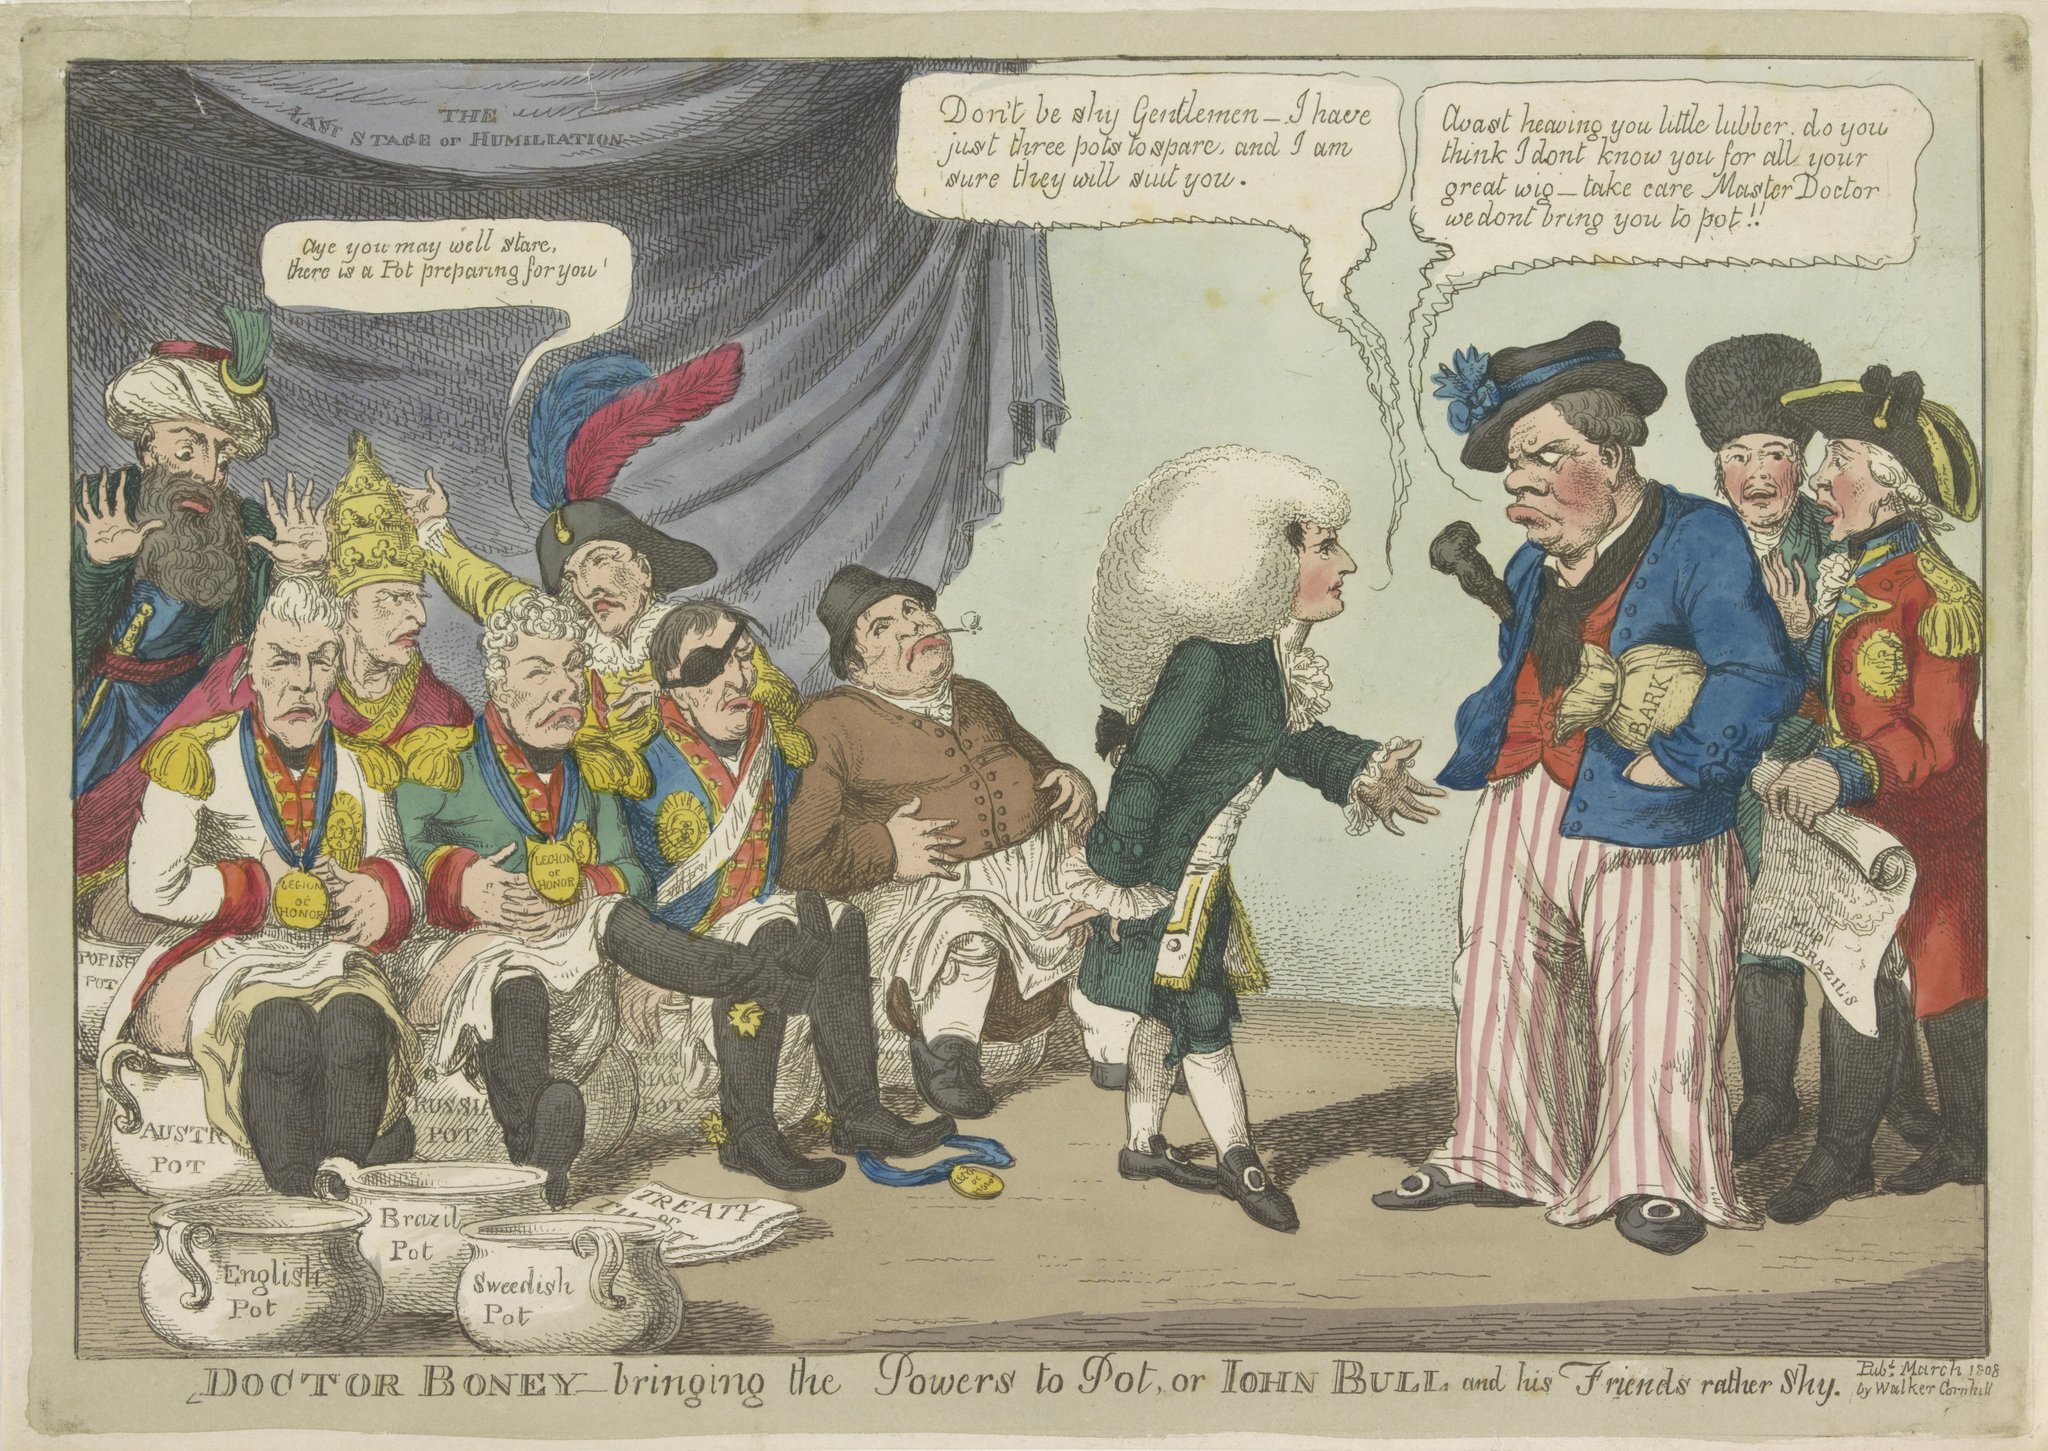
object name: cartoon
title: Dokter Napoleon zet de Europese vorsten op de pot, 1808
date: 1803-1808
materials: paper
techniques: etching, hand coloring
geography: london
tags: rome, clergyman, pius vii, naples, karel iv (koning van spanje), vienna, frans ii (rooms-duits keizer), napoleon i (emperor of the french), alexander i (tsaar van rusland), berlin, frederik willem iii koning van pruisen, personifications of countries, nations, states, districts, etc., chamber-pot, defecation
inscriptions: collector's mark: Lugt 2760, collector's mark: Lugt 2228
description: Napoleon als arts met een grote pruik op het hoofd heeft een groep Europese vorsten op een po te kakken gezet. Hij nodigt John Bull (Groot-Brittannië), Zweden (Gustaaf IV Adolf) en Brazilië (Johan VI, koning van Portugal en prins van Brazilië) uit om niet verlegen te zijn en ook plaats op de po's te nemen. Op de po's met de broek om de knieën zitten al tsaar Alexander I, Frederik Willem III van Pruisen, keizer Frans II, paus Pius VII, de Spaanse koning Karel IV en een dikke Hollander. Sultan Mustafa IV kijkt verschrikt toe.